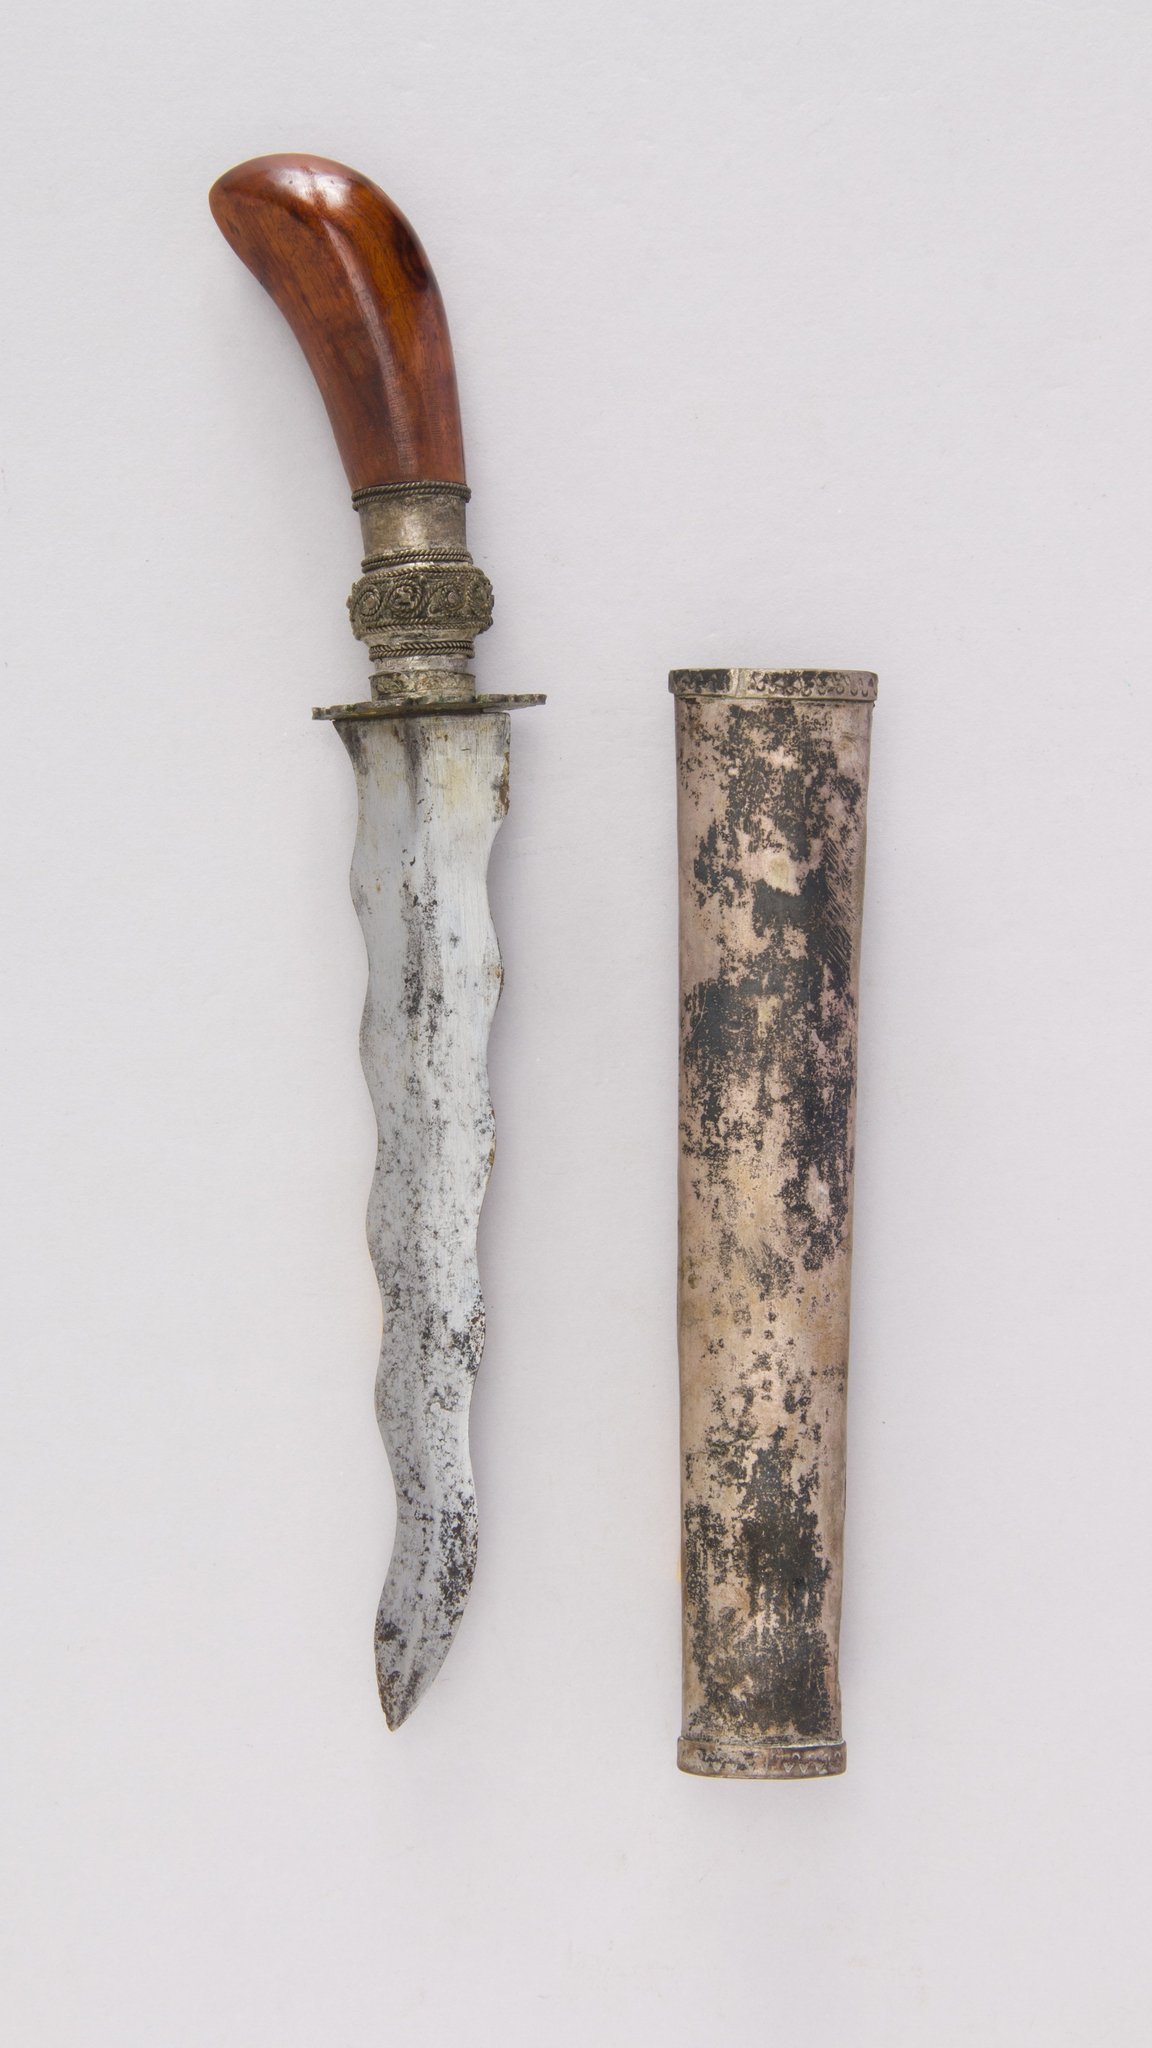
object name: dagger with sheath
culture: philippine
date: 1801-1900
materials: silver, steel, metal, wood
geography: philippines